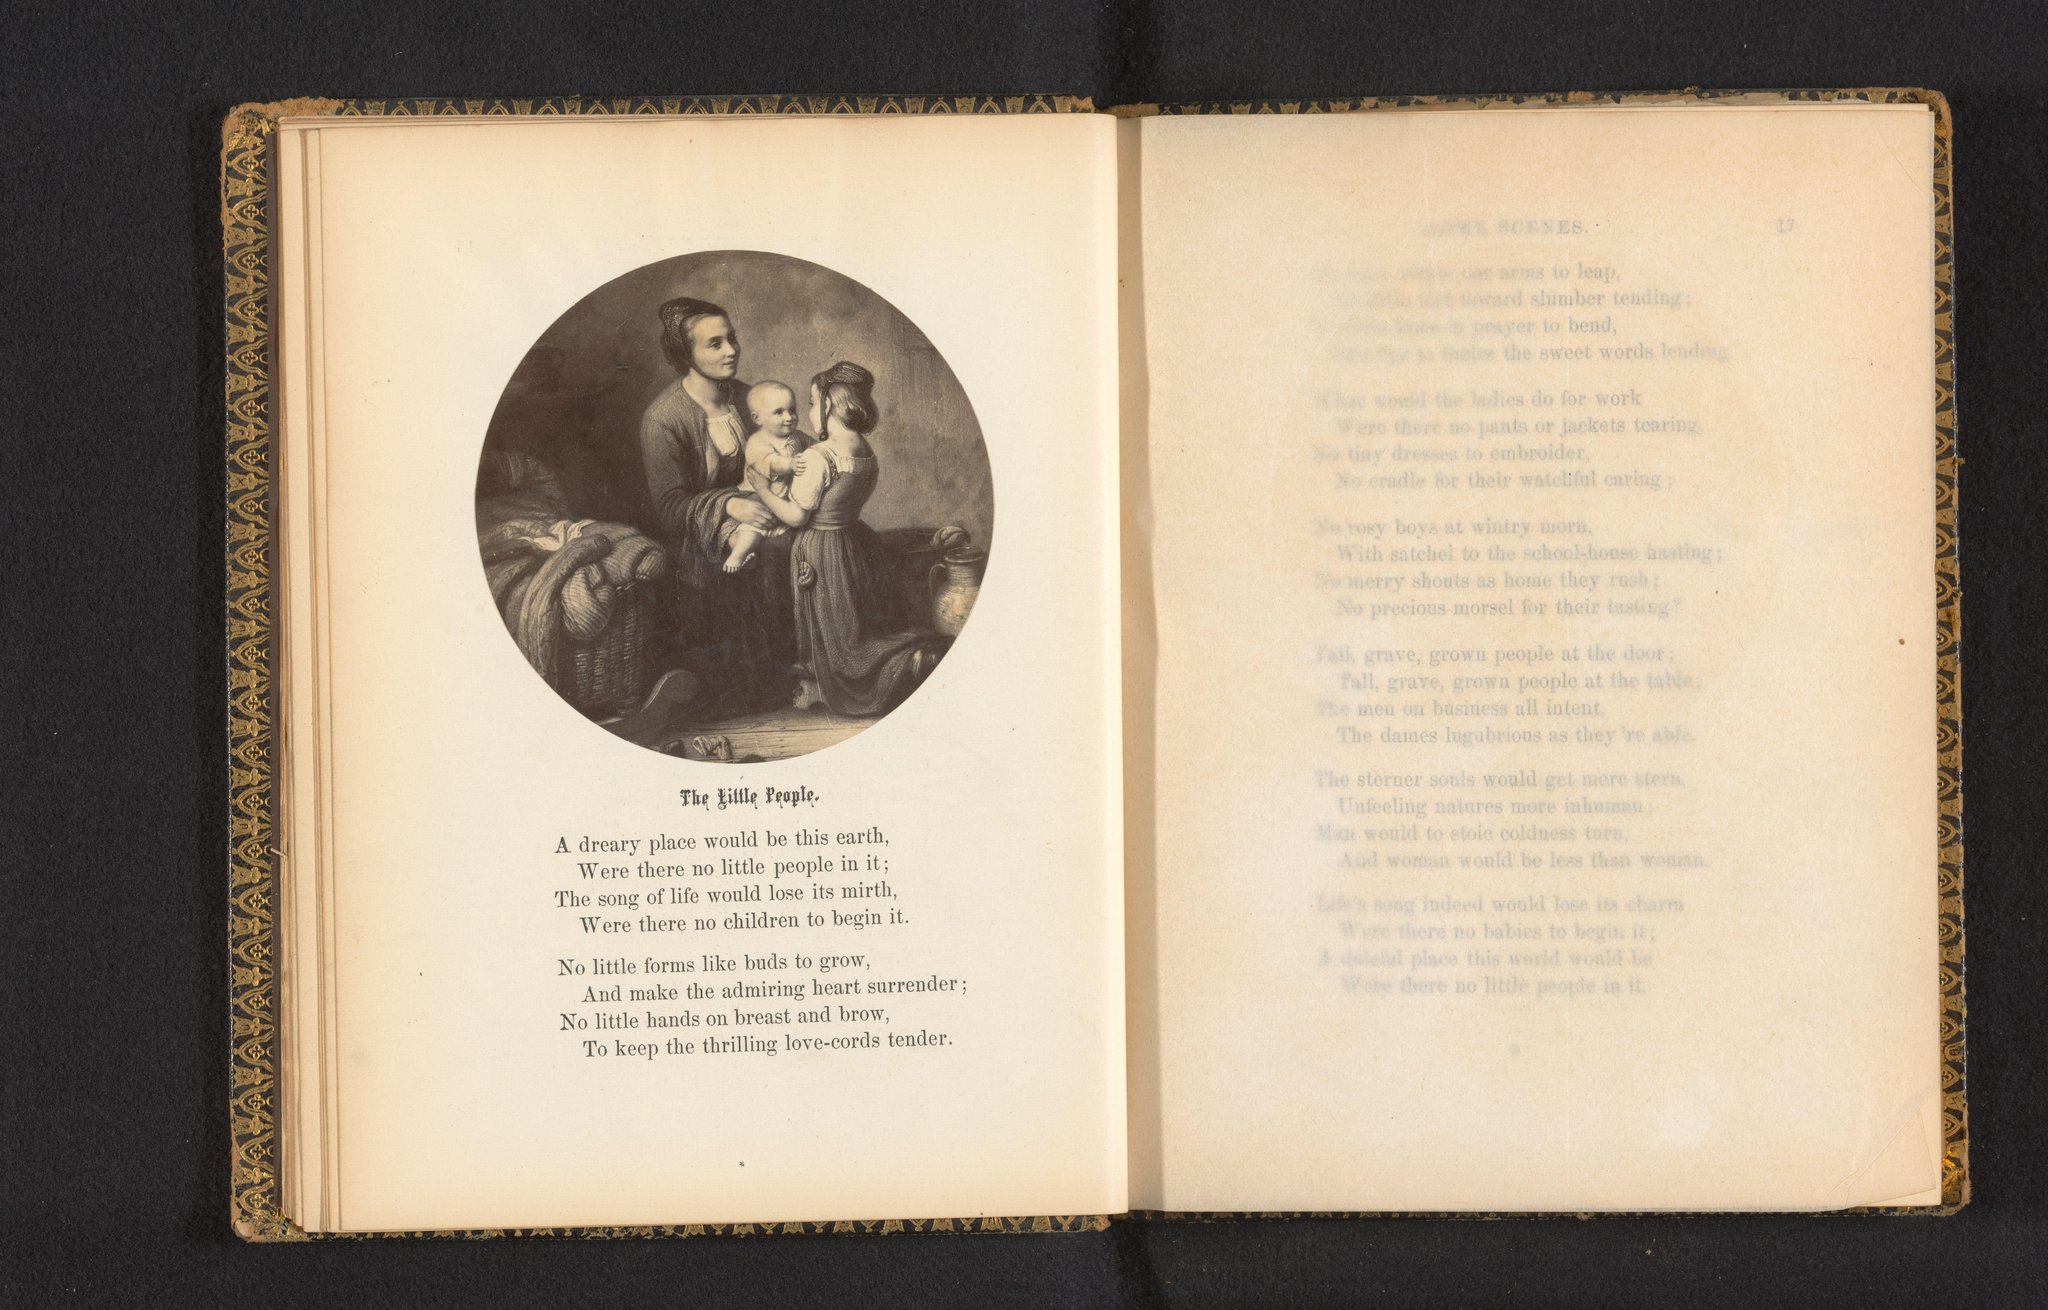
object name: page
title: The little people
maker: Anonymous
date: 1860-1865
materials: photographic support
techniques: albumen print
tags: mother and child(ren), woman and child(ren) (family group)